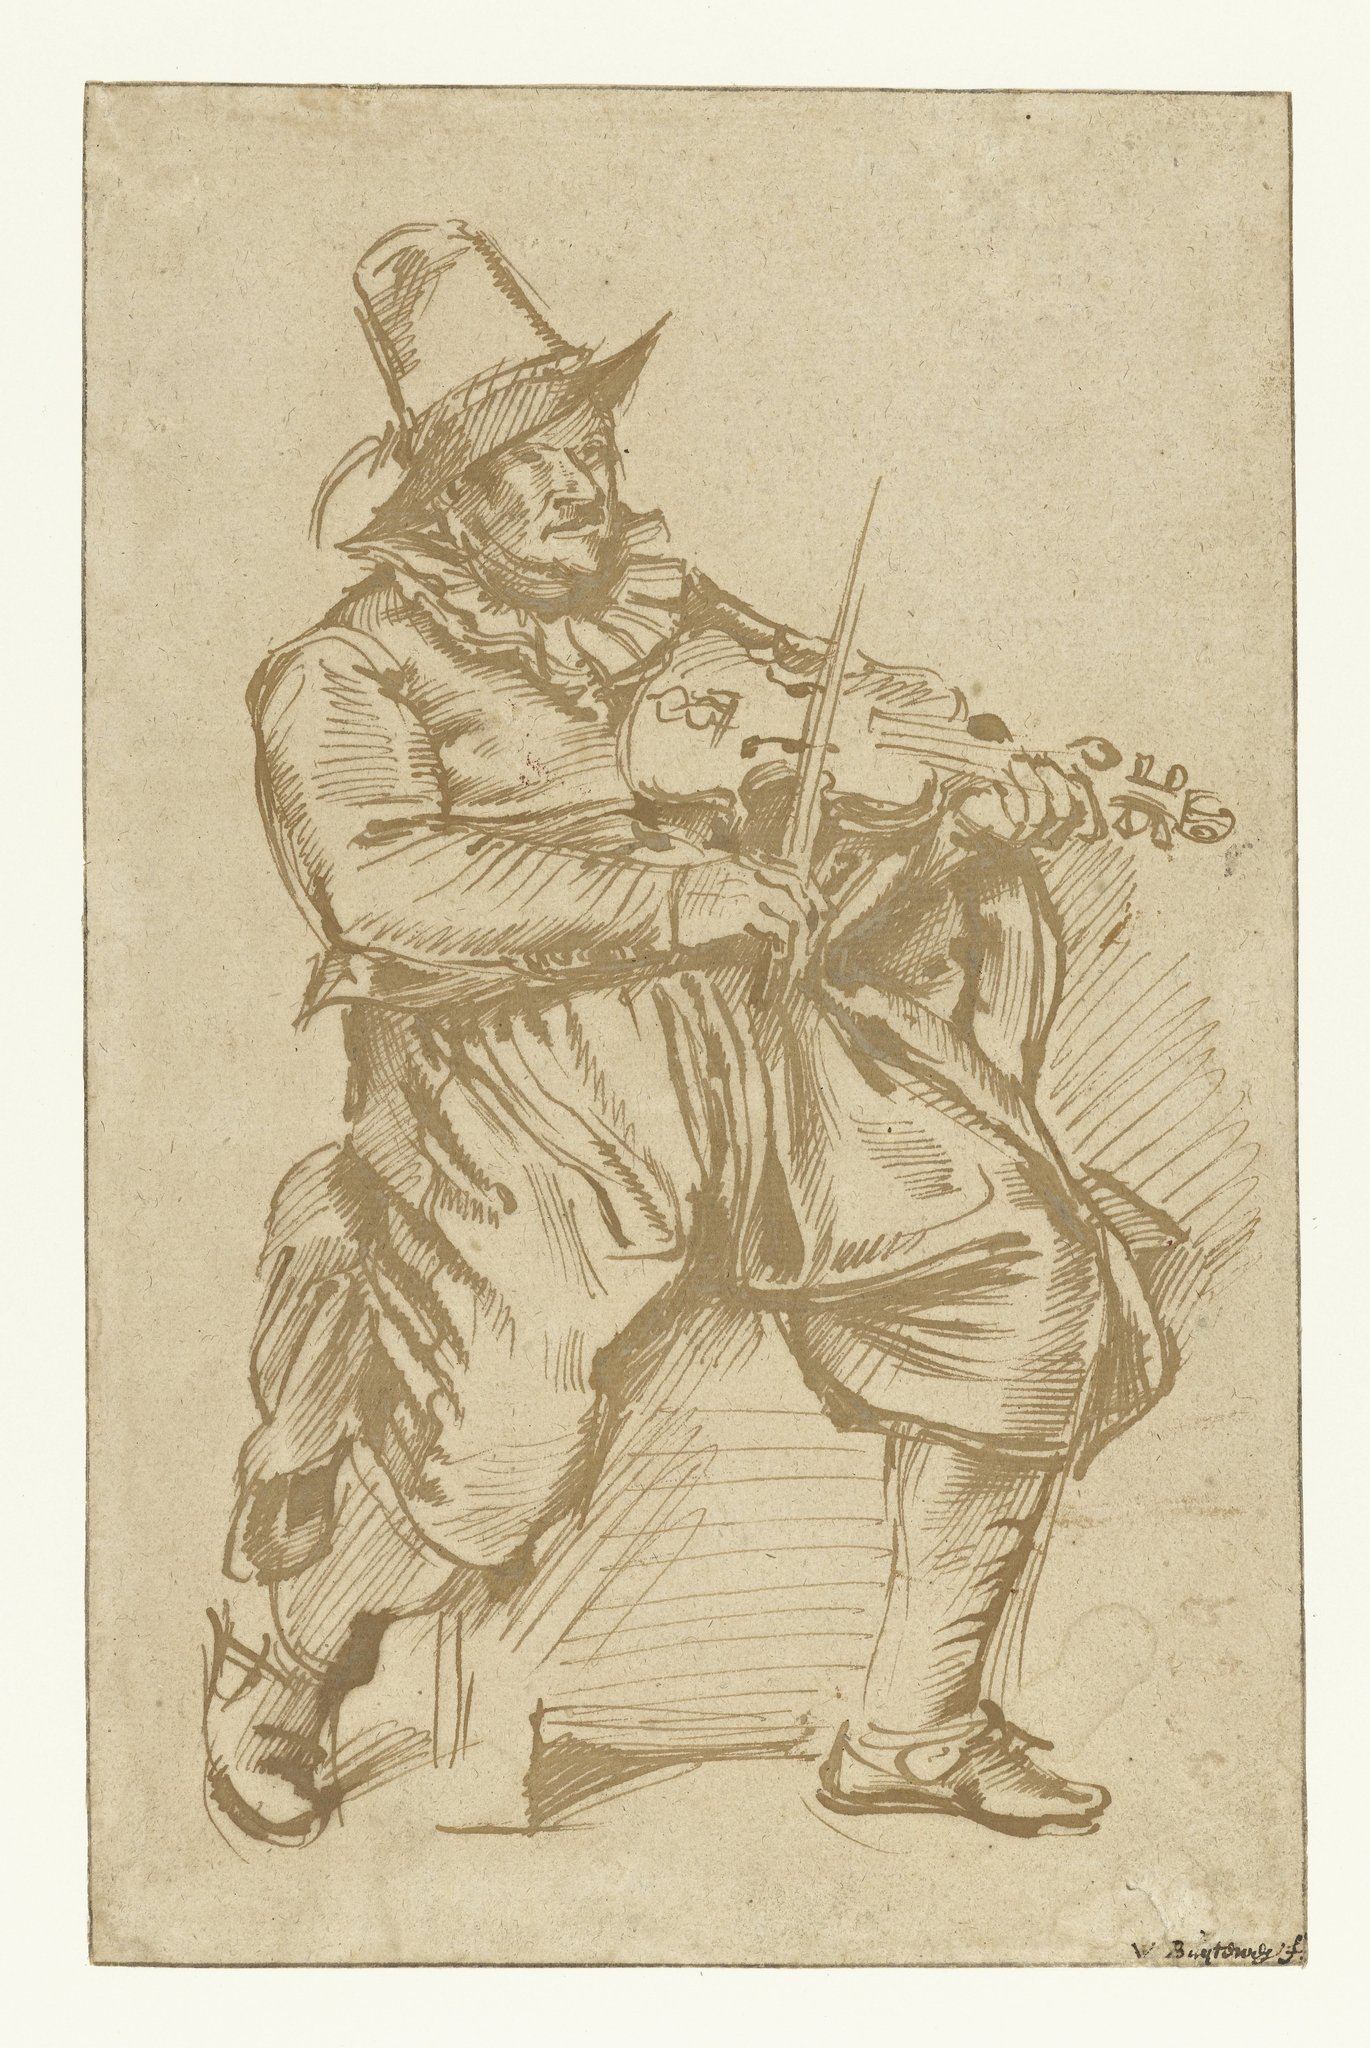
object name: drawing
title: Seated Violin Player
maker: willem pietersz buytewech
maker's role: draughtsman, print maker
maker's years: 1592-1624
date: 1620-1624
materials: ink, paper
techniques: pen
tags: violin, fiddle